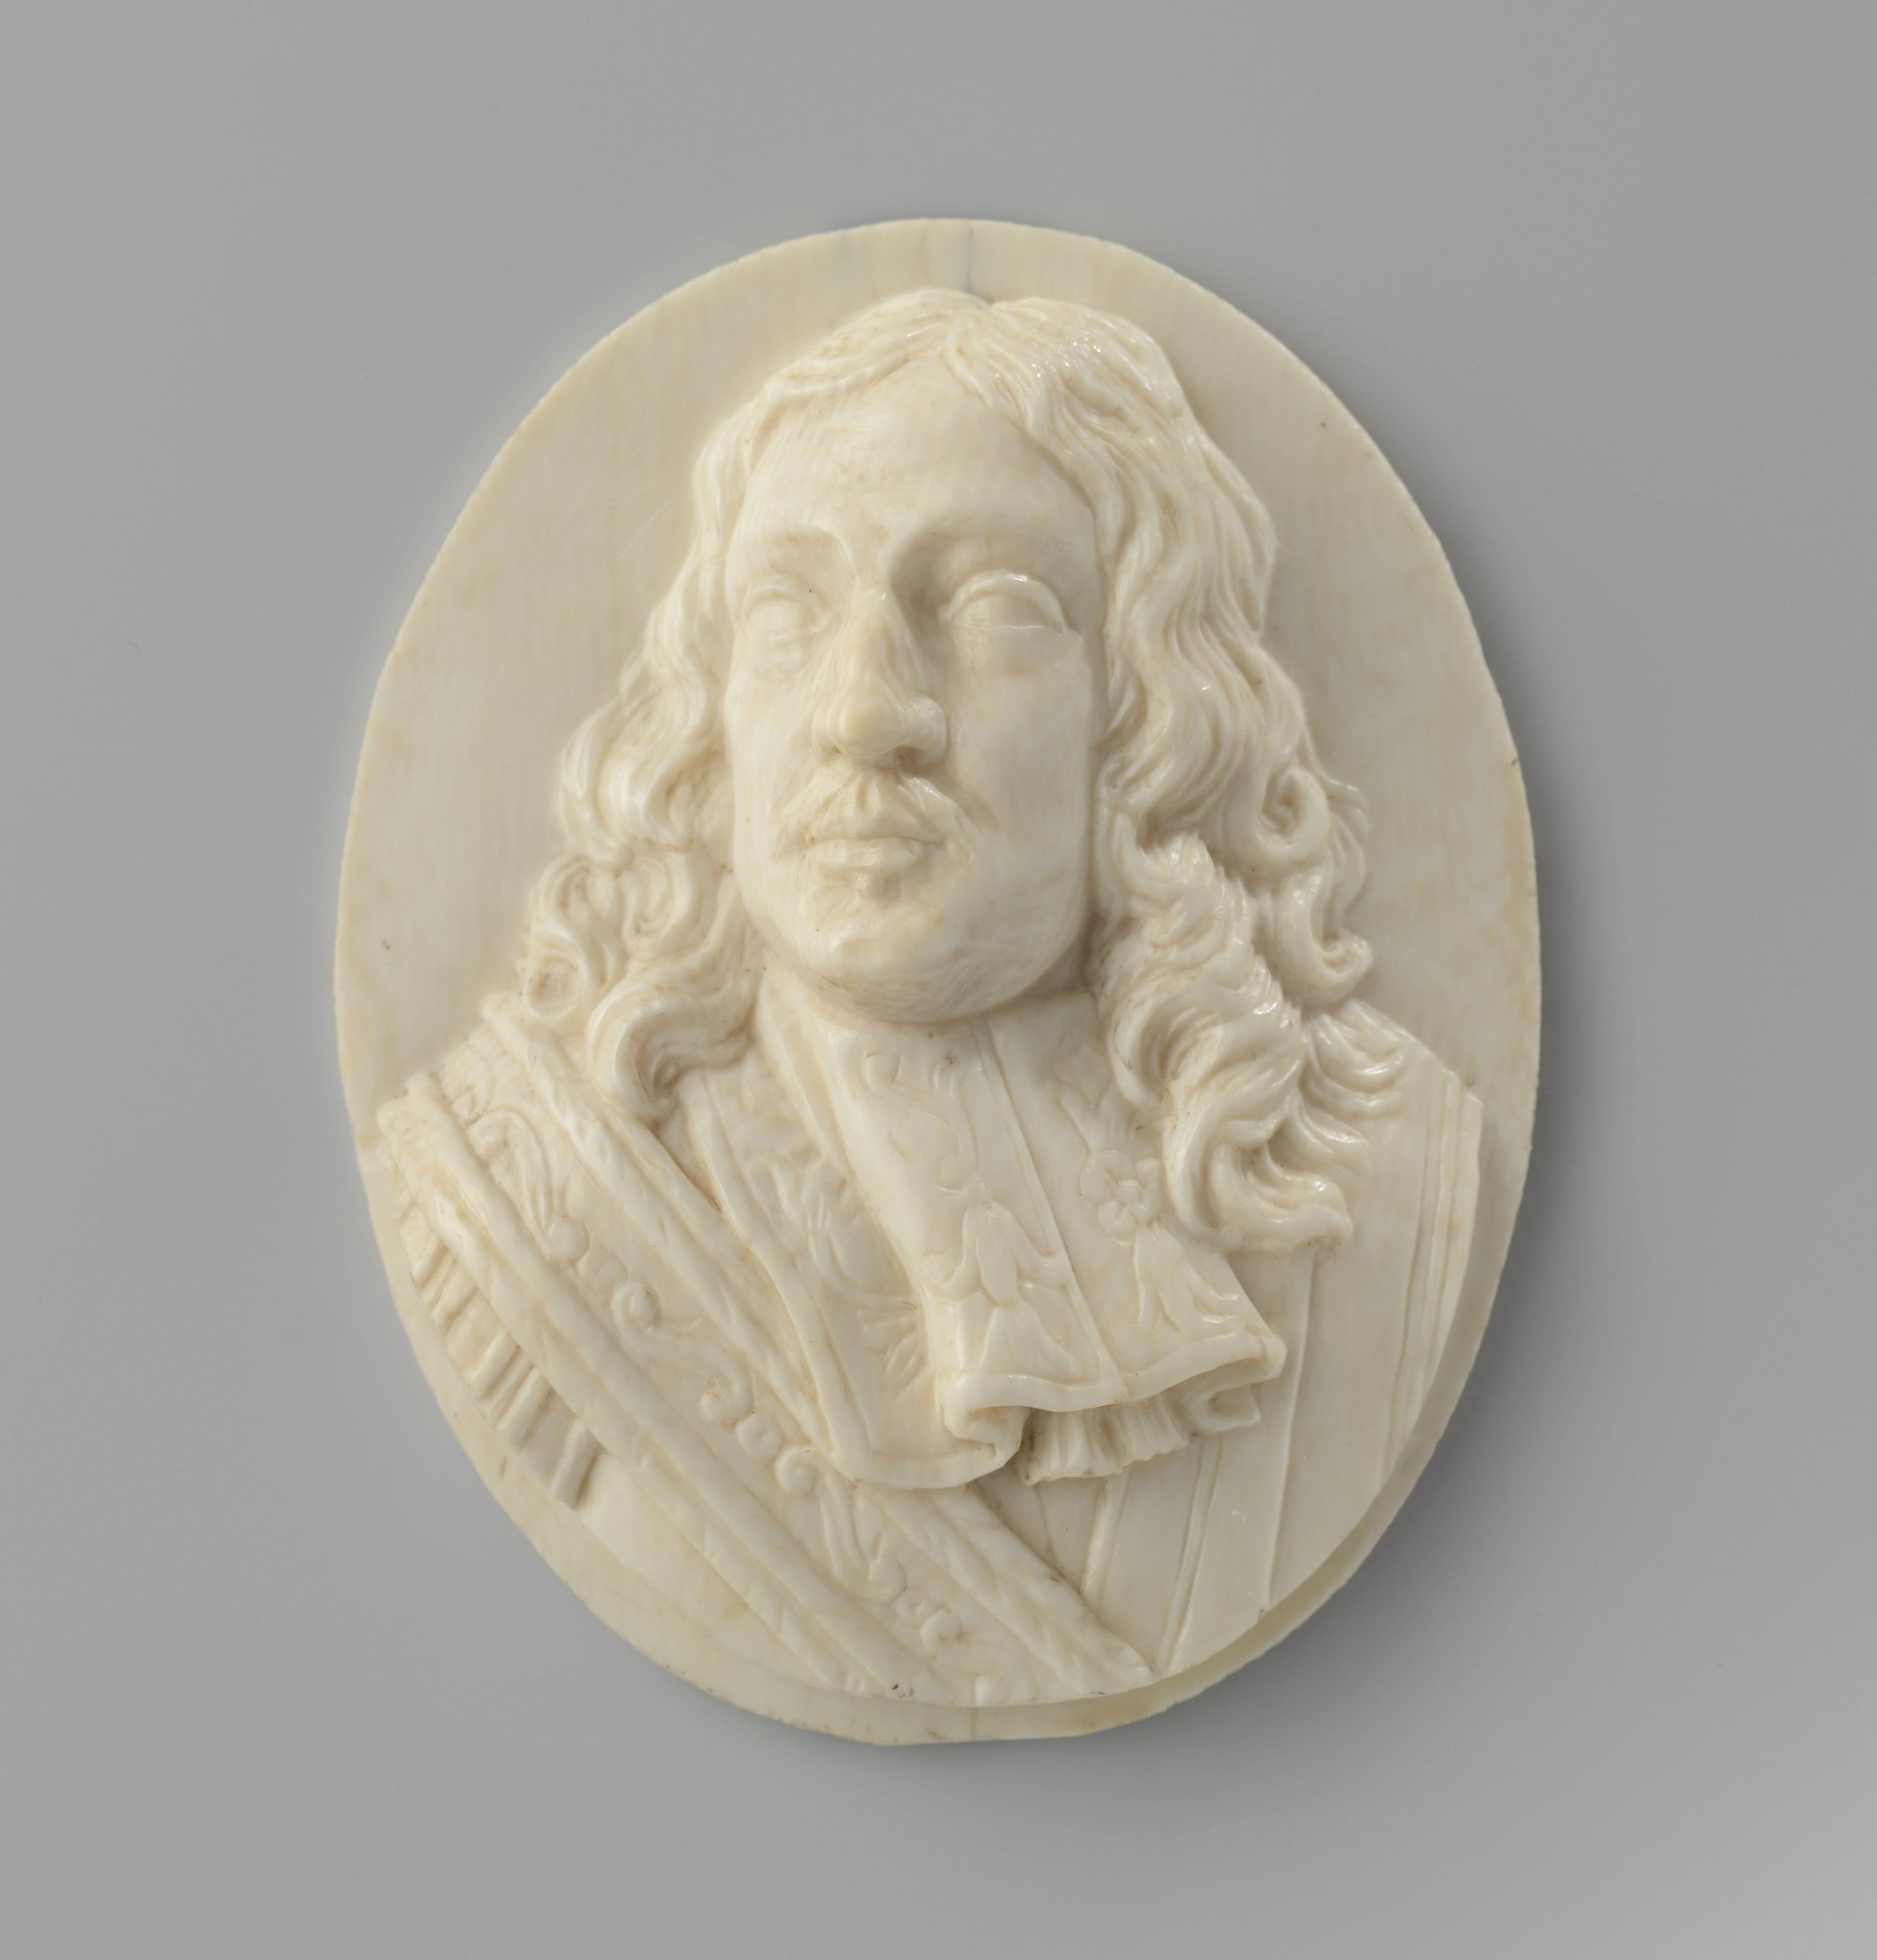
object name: relief sculpture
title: Portrait Medallion of Cornelis de Witt (1623-1672)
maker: Anonymous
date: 1735-1750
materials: ivory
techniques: cutting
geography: netherlands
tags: cornelis de witt, historical persons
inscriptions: inscription, on the reverse, in ink: ‘Cornelis de Witt / D. Franken Dz’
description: Portrait medallions of the De Witt brothers. Ivory, Northern Netherlands, 17th century.